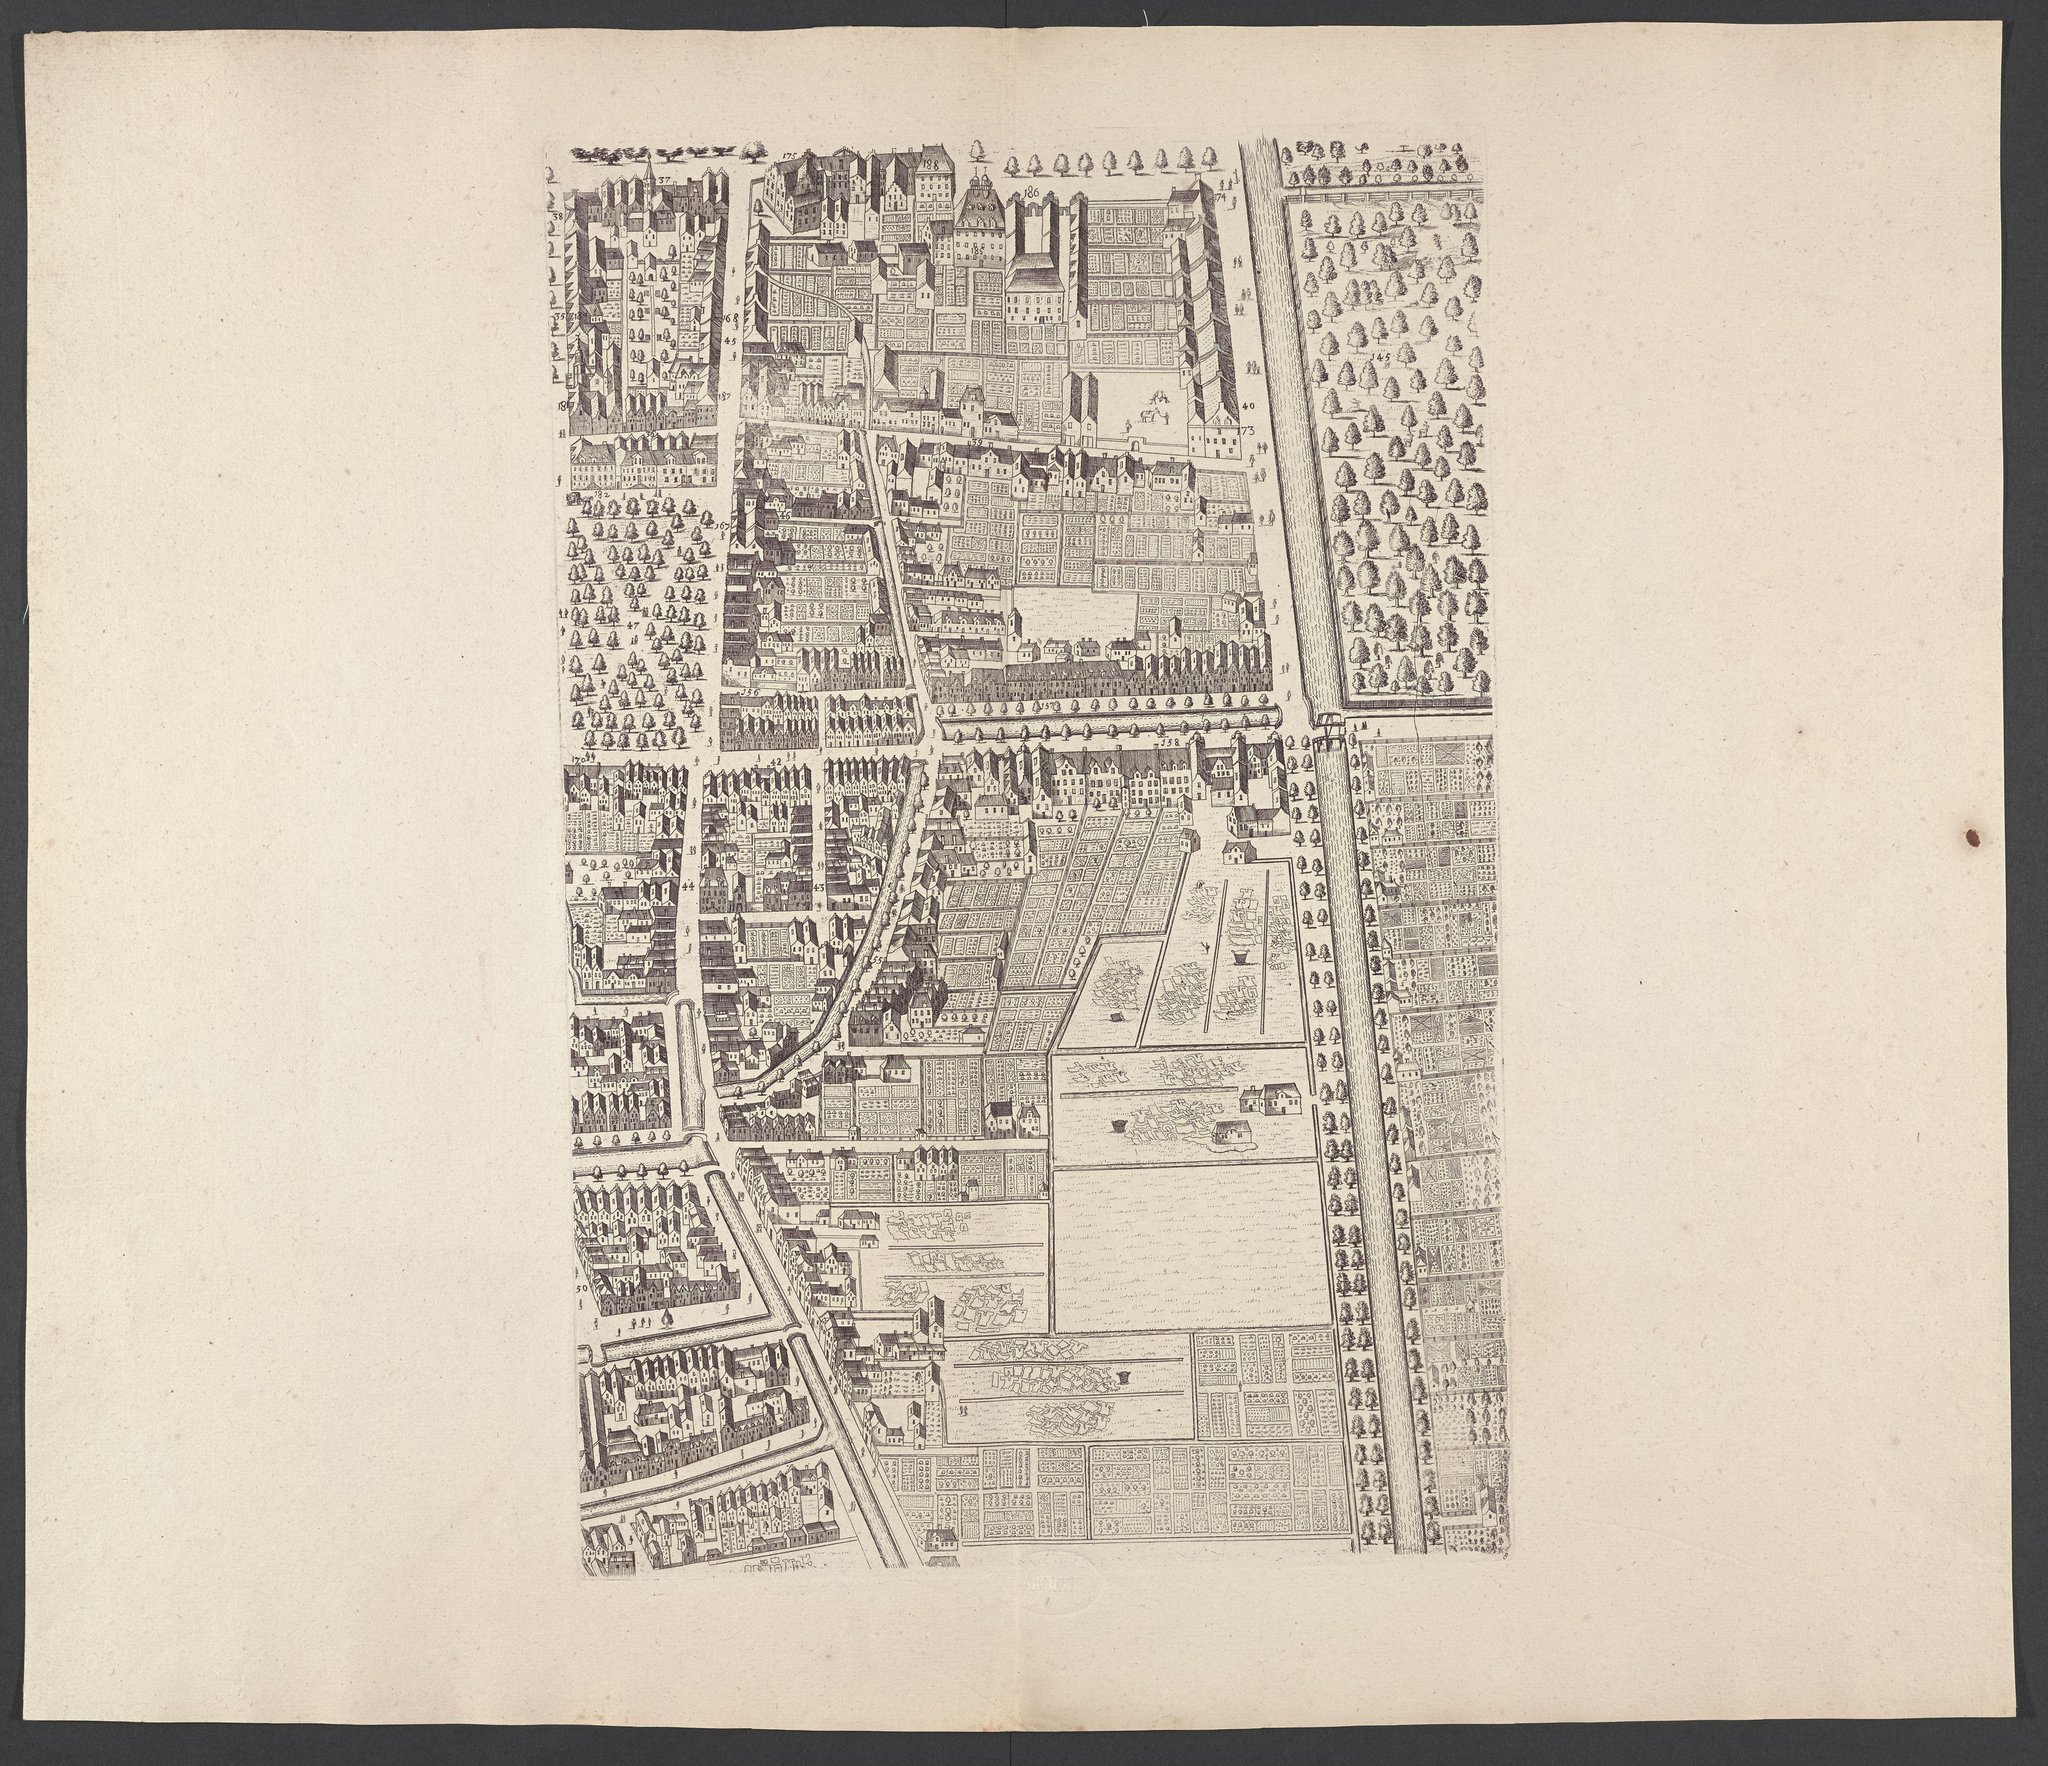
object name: print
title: Plattegrond van de figuratieve kaart van Den Haag (achtste deel)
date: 1665-1667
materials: paper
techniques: etching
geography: amsterdam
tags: maps of cities, the hague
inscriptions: collector's mark: Lugt 2228, check stamp: ‘Archief Ministerie van Oorlog Afdeeling Genie’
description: Deze prent is onderdeel van een plattegrond van Den Haag. Deze staat van de plattegrond werd oorspronkelijk uitgegeven met een sierrand, bestaande uit een gezicht op de stad en veertien kleinere gezichten in en om Den Haag, en vormde zo de zogenaamde figuratieve kaart van Den Haag. Voor de prenten die de rand vormen, zie: RP-P-AO-12-8, RP-P-AO-12-8-2, RP-P-OB-50.201, RP-P-OB-50.202, RP-P-OB-50.203, RP-P-OB-50.204, RP-P-OB-50.205, RP-P-OB-50.206, RP-P-OB-50.207, RP-P-OB-50.208, RP-P-OB-102.387, RP-P-OB-50.209, RP-P-OB-50.210, RP-P-OB-50.211, RP-P-OB-50.212, RP-P-OB-50.213, RP-P-AO-12-5-4 en RP-P-OB-50.214.